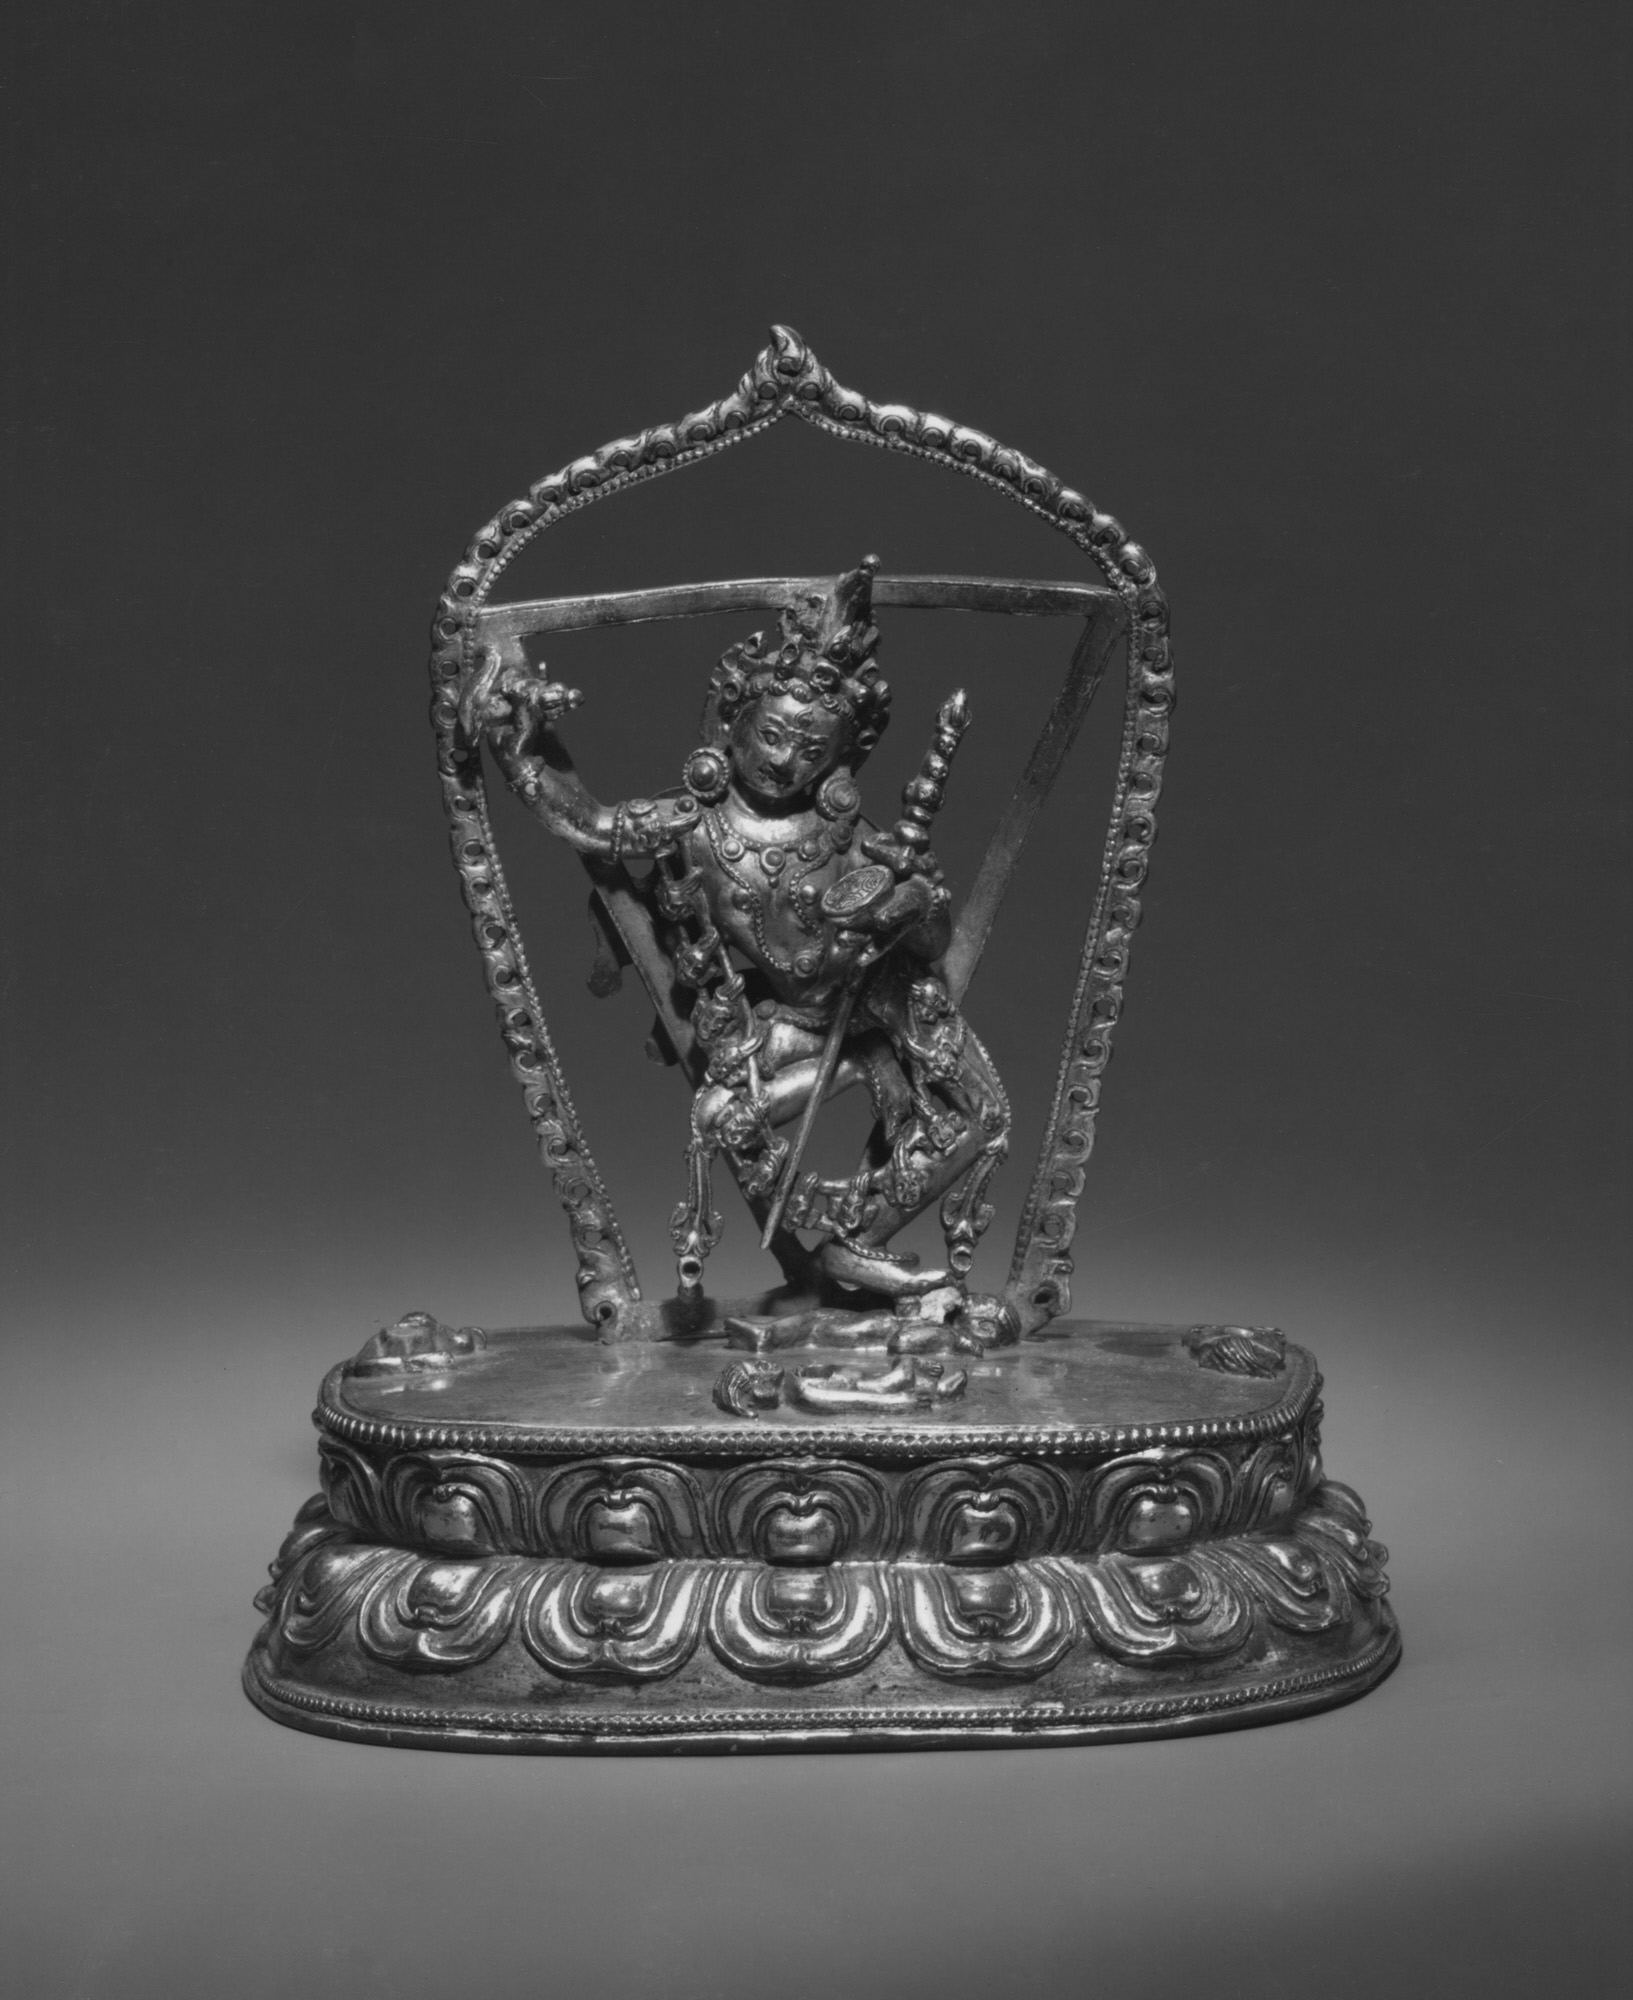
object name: figure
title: Vajravarahi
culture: tibetan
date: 1601-1700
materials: copper alloy, gilt, stone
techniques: inlay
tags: deities